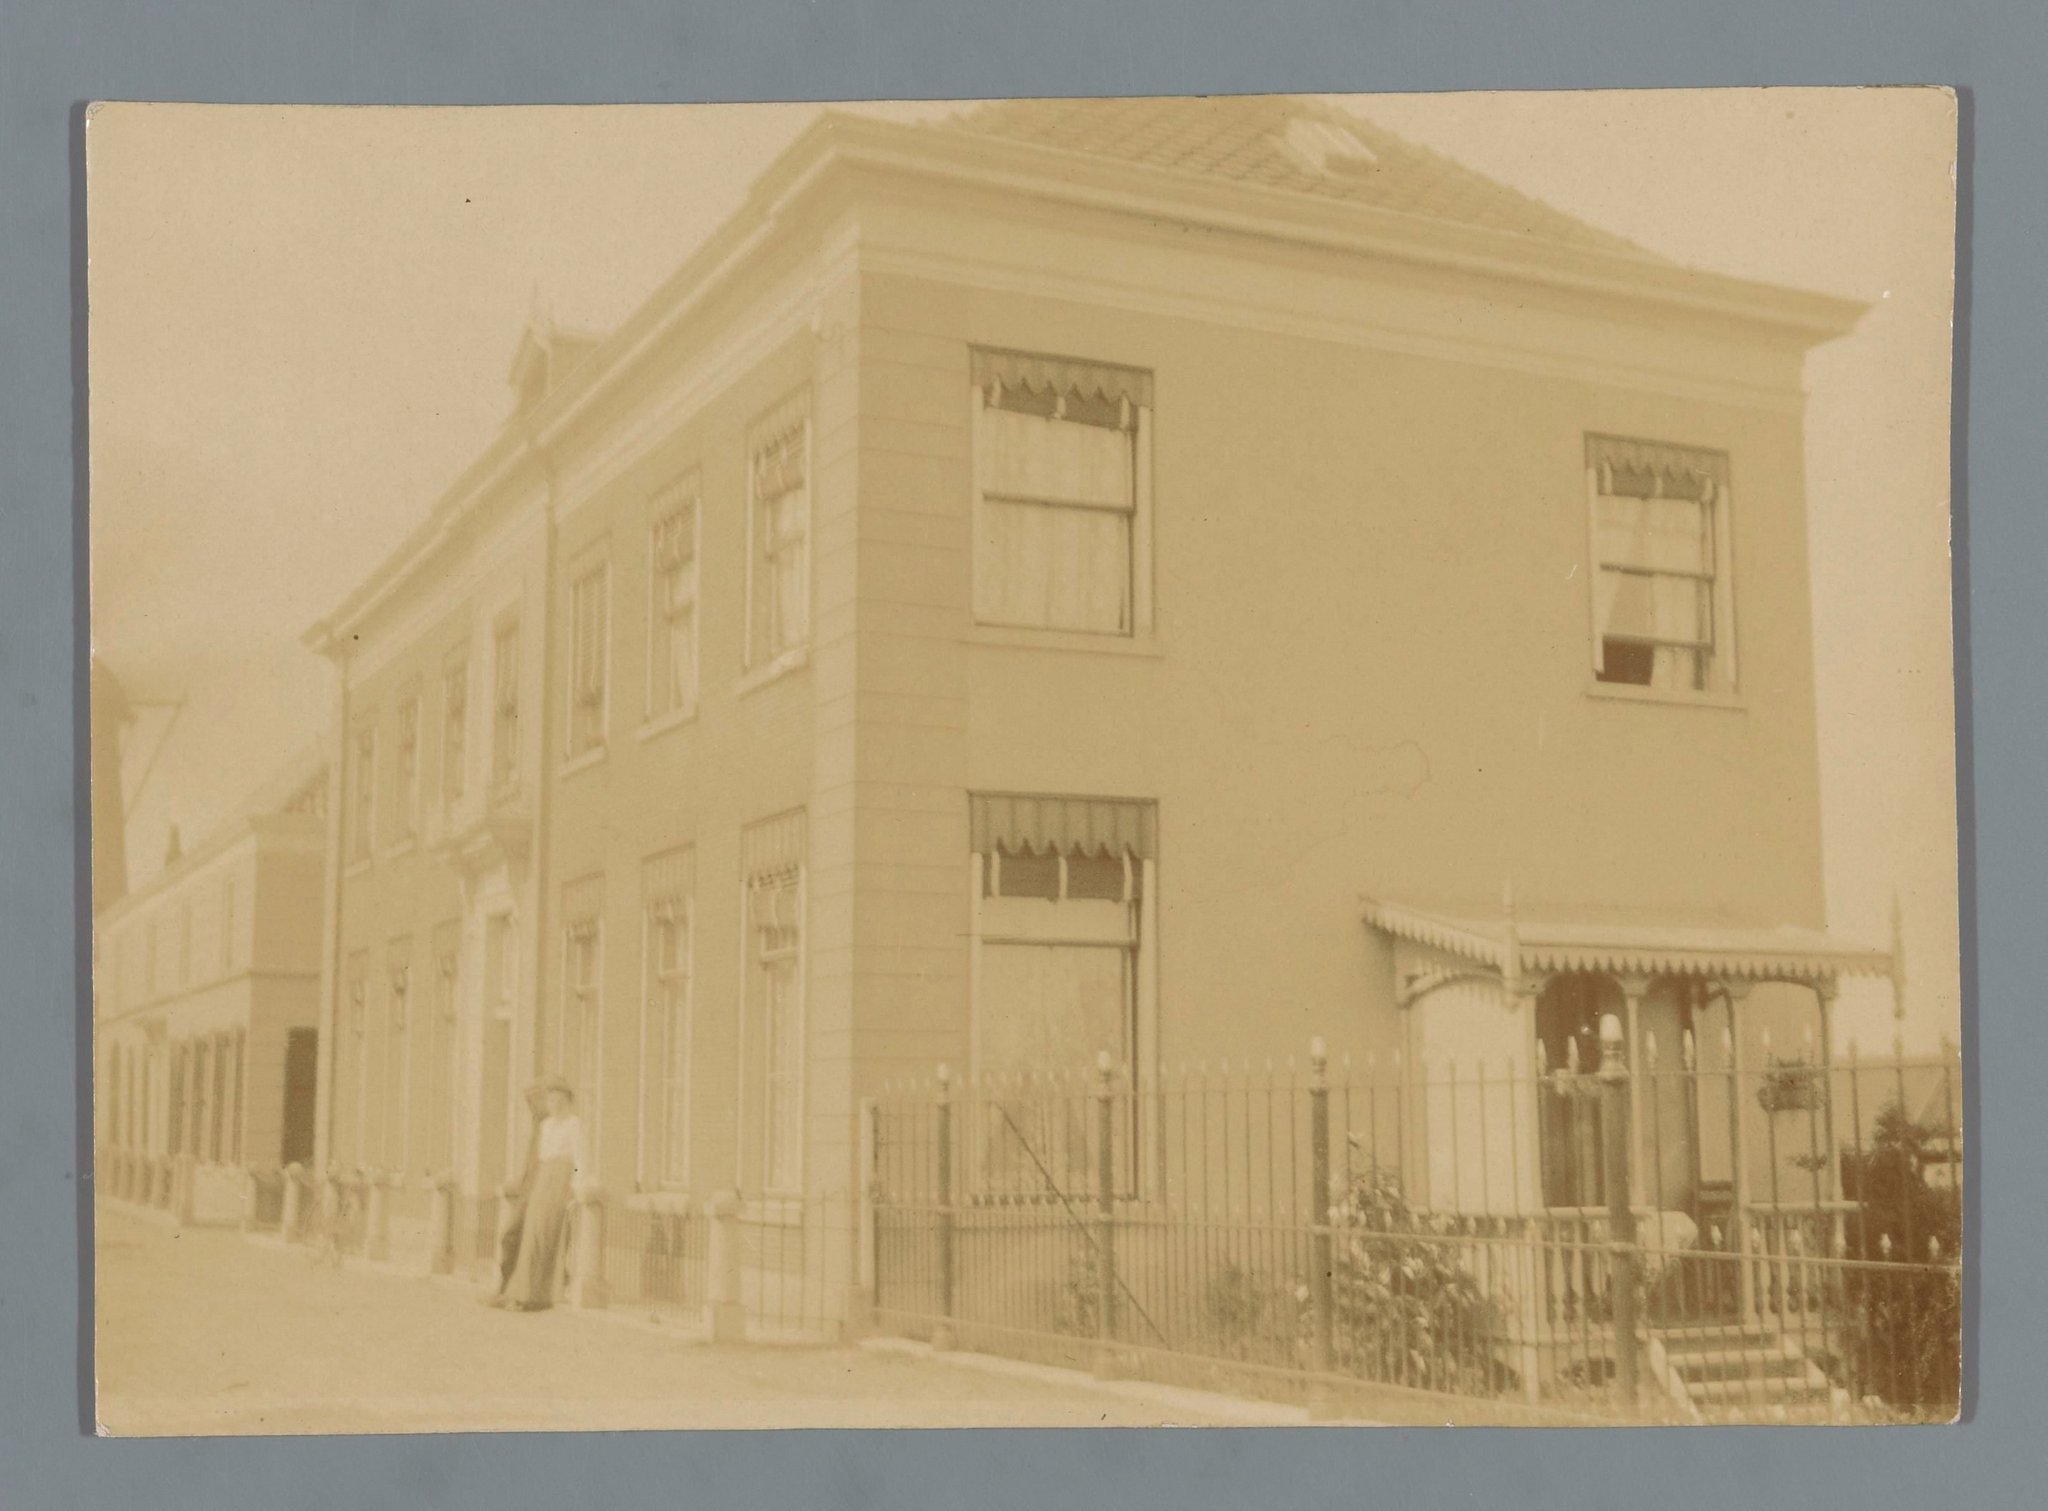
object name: photograph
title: Exterieur van een woonhuis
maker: Anonymous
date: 1890-1910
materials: photographic support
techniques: gelatin silver print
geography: netherlands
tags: housing, façade (of house or building)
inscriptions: inscription: ‘[...]inge[...]’